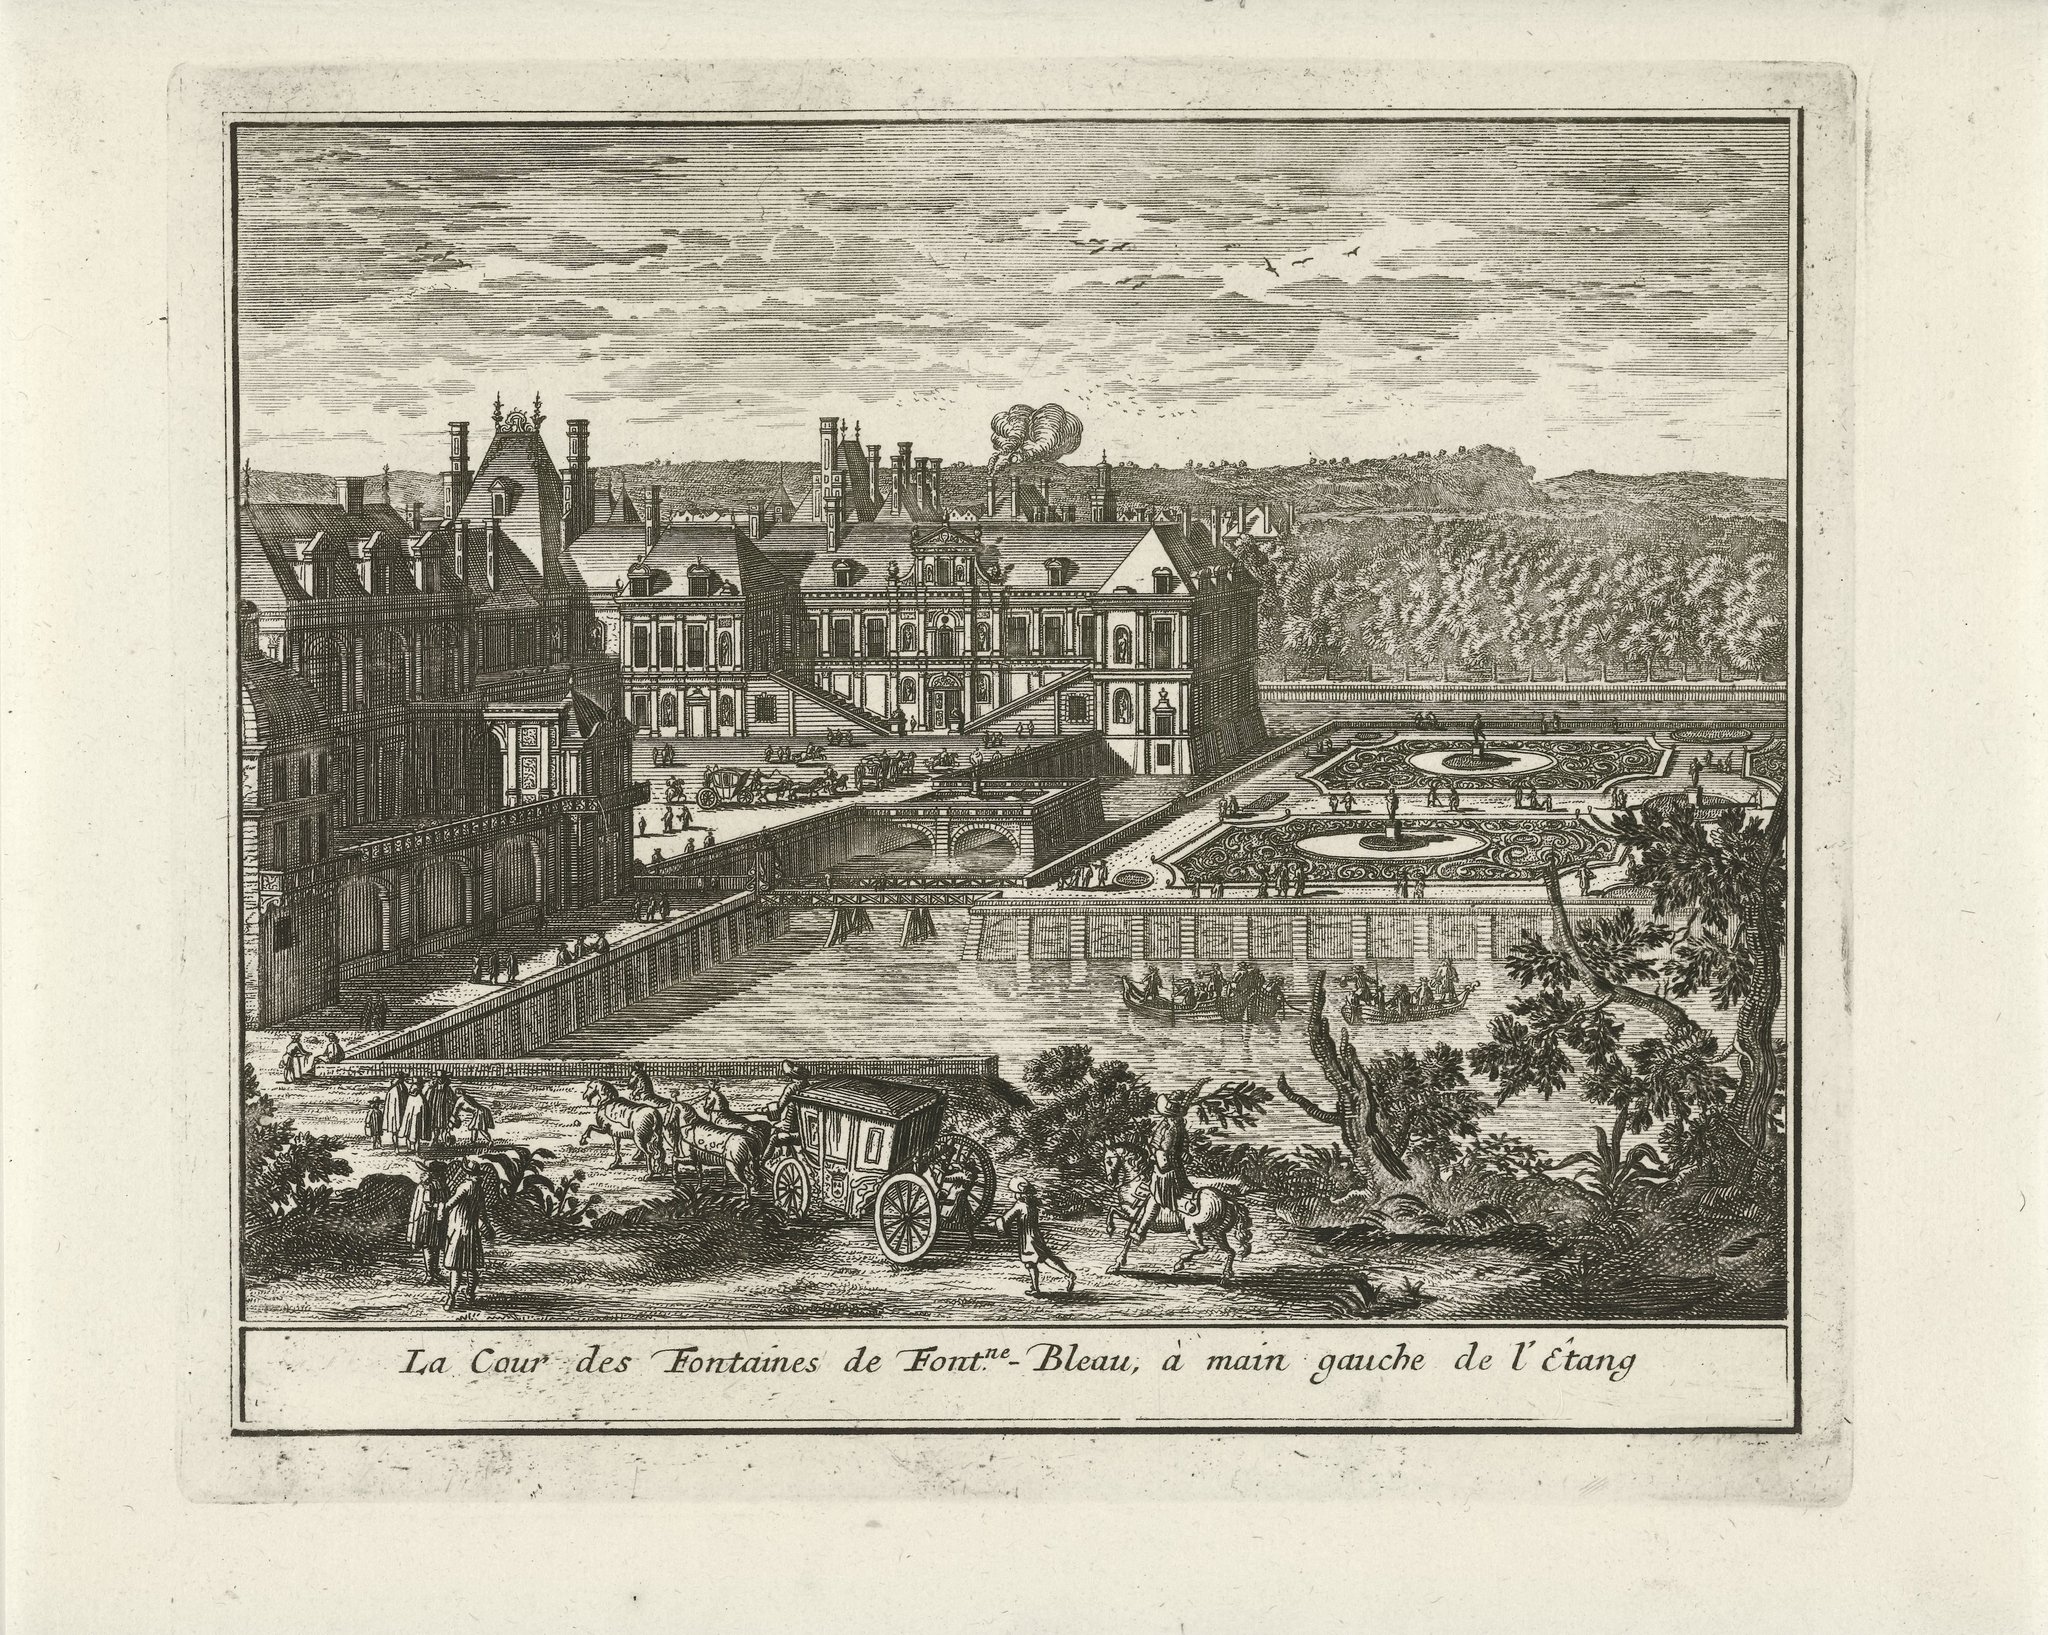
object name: print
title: La Cour des Fontaines de Fontne. Bleau, à main gauche de l'Etang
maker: jan lamsvelt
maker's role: print maker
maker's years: 1674-1743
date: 1726-1743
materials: paper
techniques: etching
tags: palace, courtyard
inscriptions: collector's mark: Lugt 2228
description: Deze prent is tevens opgenomen in deel III van het prentwerk: Les Forces de l'Europe, Asie, Afrique et Amerique ... Comme aussi les Cartes des Côtes de France et d'Espagne (1726). Dit is het eerste deel met 238 met de hand genummerde platen van vermaarde sterke steden en vestingen in het kader van de Spaanse Successieoorlog 1701-1713. Voor het merendeel zijn deze platen gekopieerd naar de anonieme Franse platen van vermaarde sterke steden en vestingen: in Les forces de l'Europe en in: Le theatre de la guerre, dans les Pays-Bas, beide oorspronkelijk uitgegeven door Nicolas de Fer te Parijs (1693-1697) in het kader van de Negenjarige Oorlog.